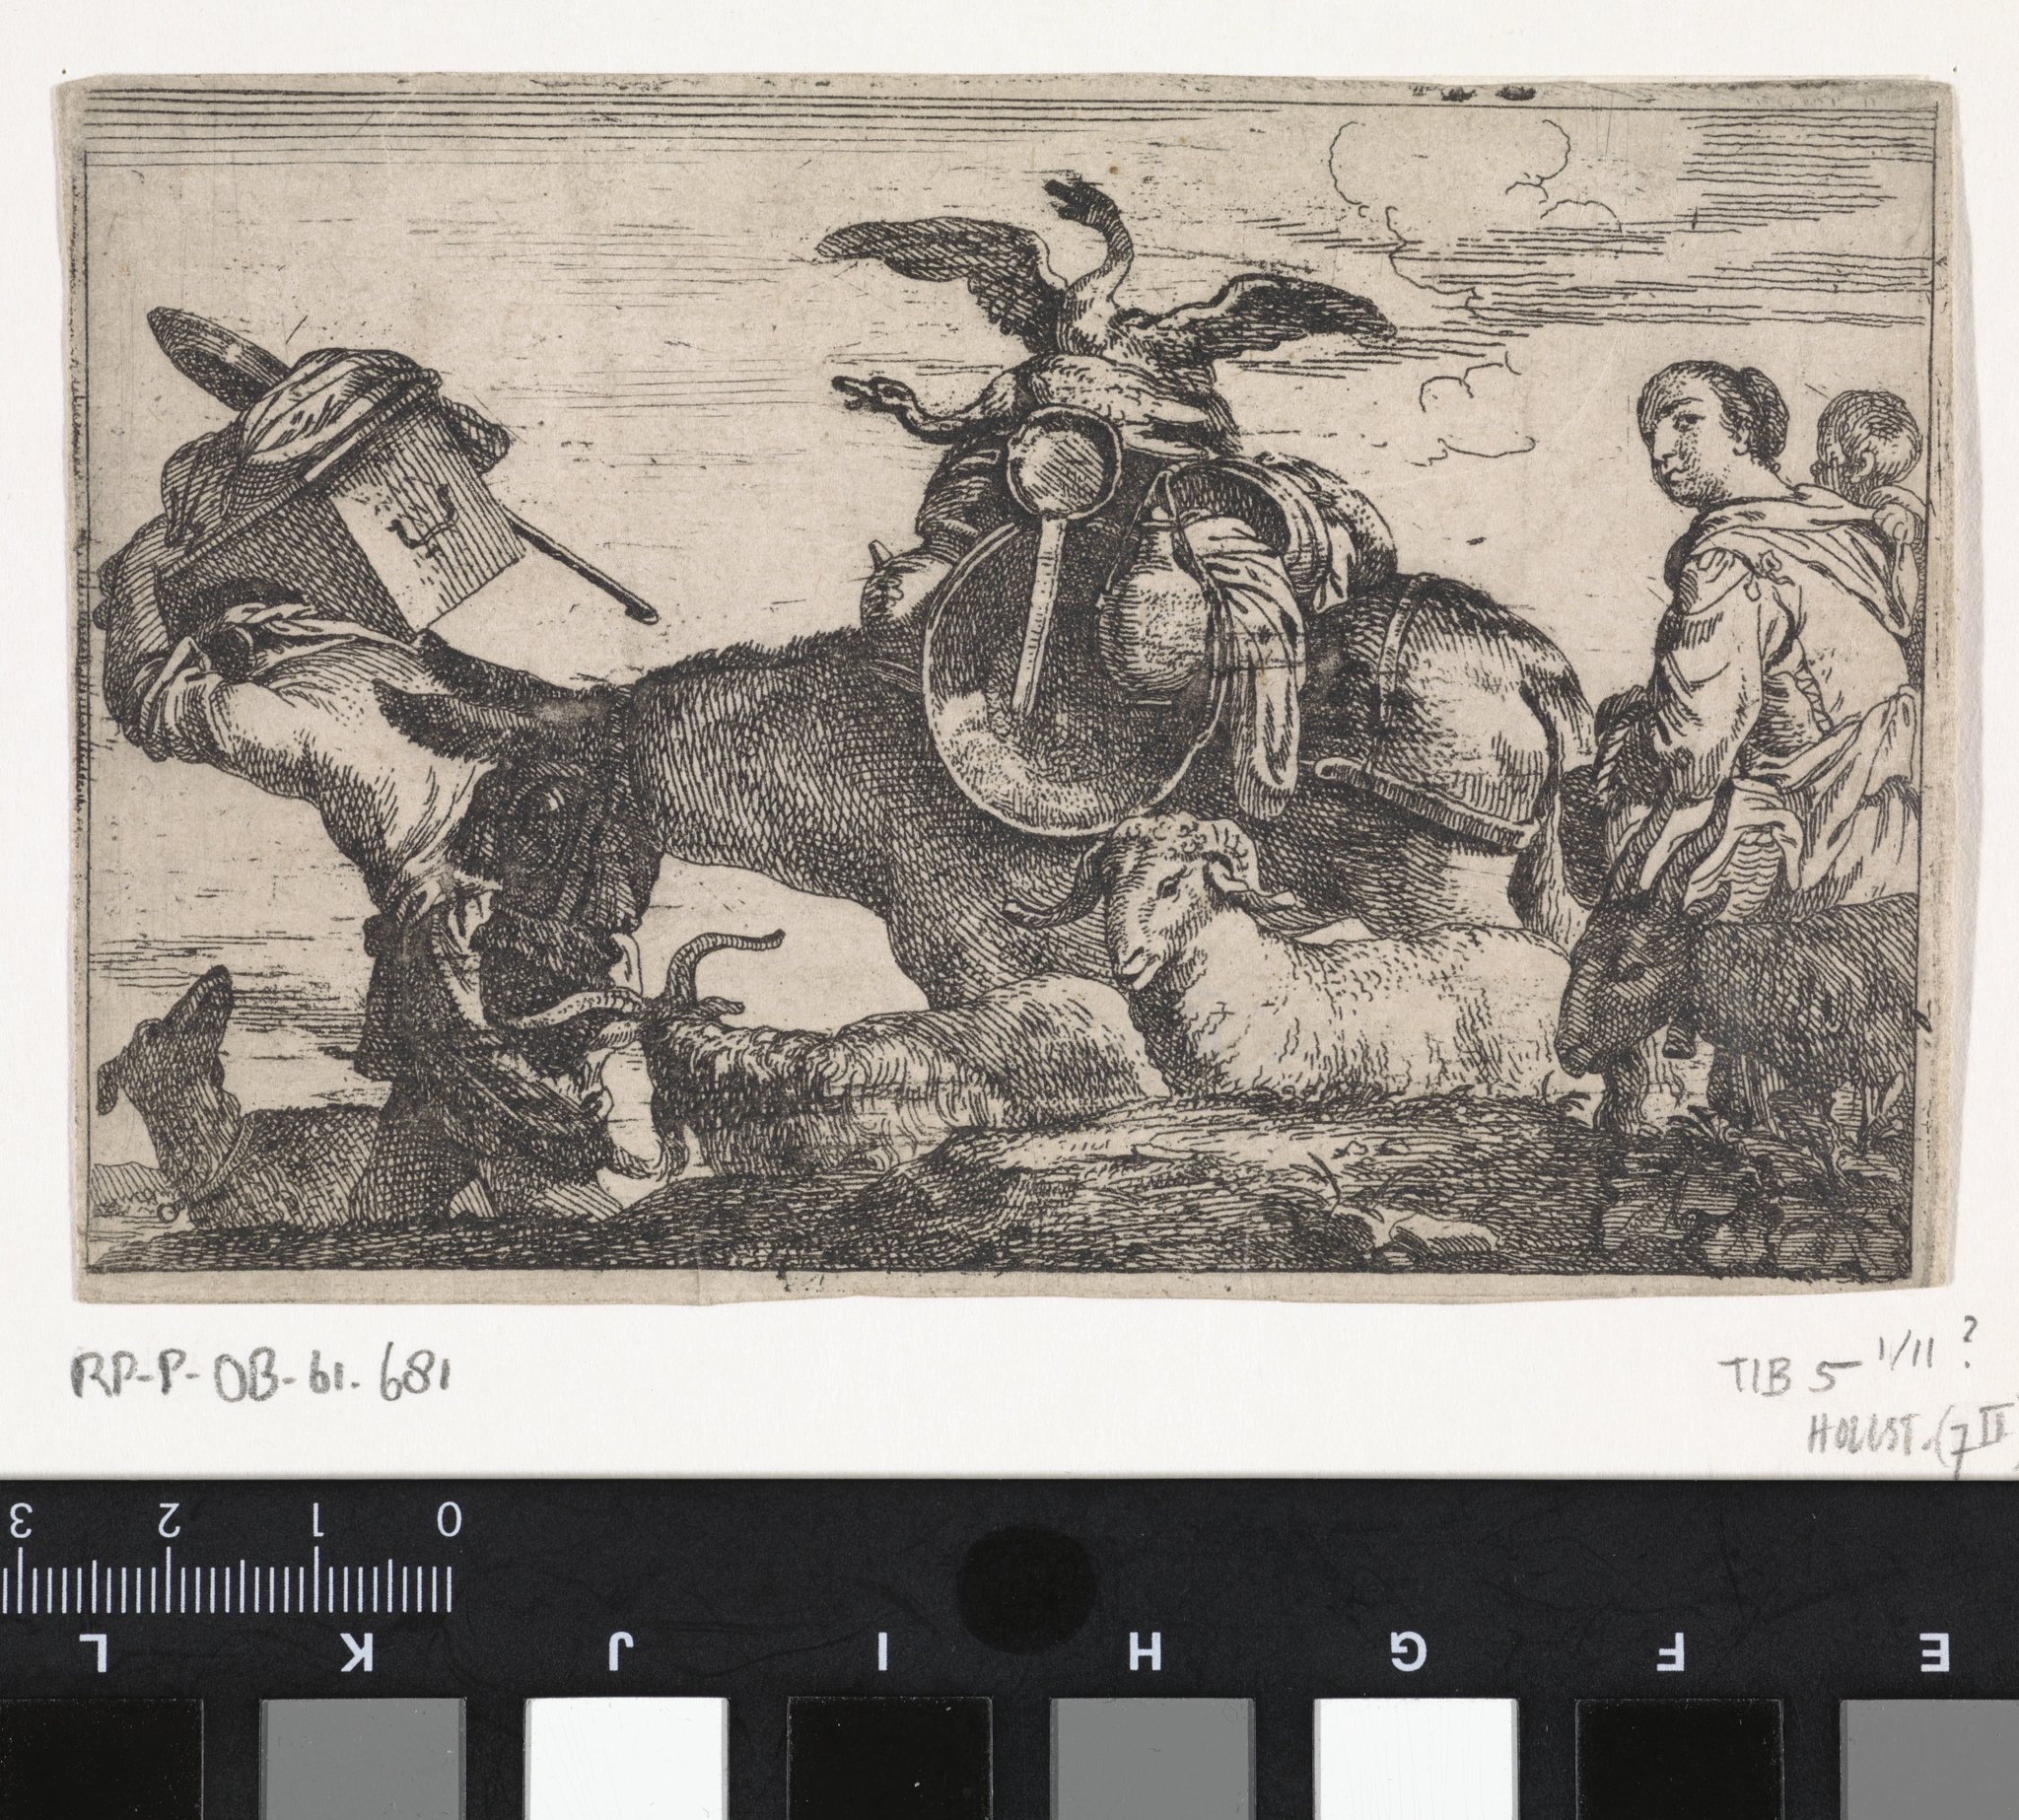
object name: print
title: Ezel beladen met twee ganzen en huisraad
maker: jan baptist de wael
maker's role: print maker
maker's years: 1632-1669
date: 1642-1669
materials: paper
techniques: etching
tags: the family travelling, on holiday, ass, donkey, furniture and household effects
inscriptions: collector's mark: Lugt 2228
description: Landschap met een familie op reis. De man draagt een doos met huisraad op zijn rug en trekt de beladen ezel voort. Zijn vrouw volgt met het kind op de arm.